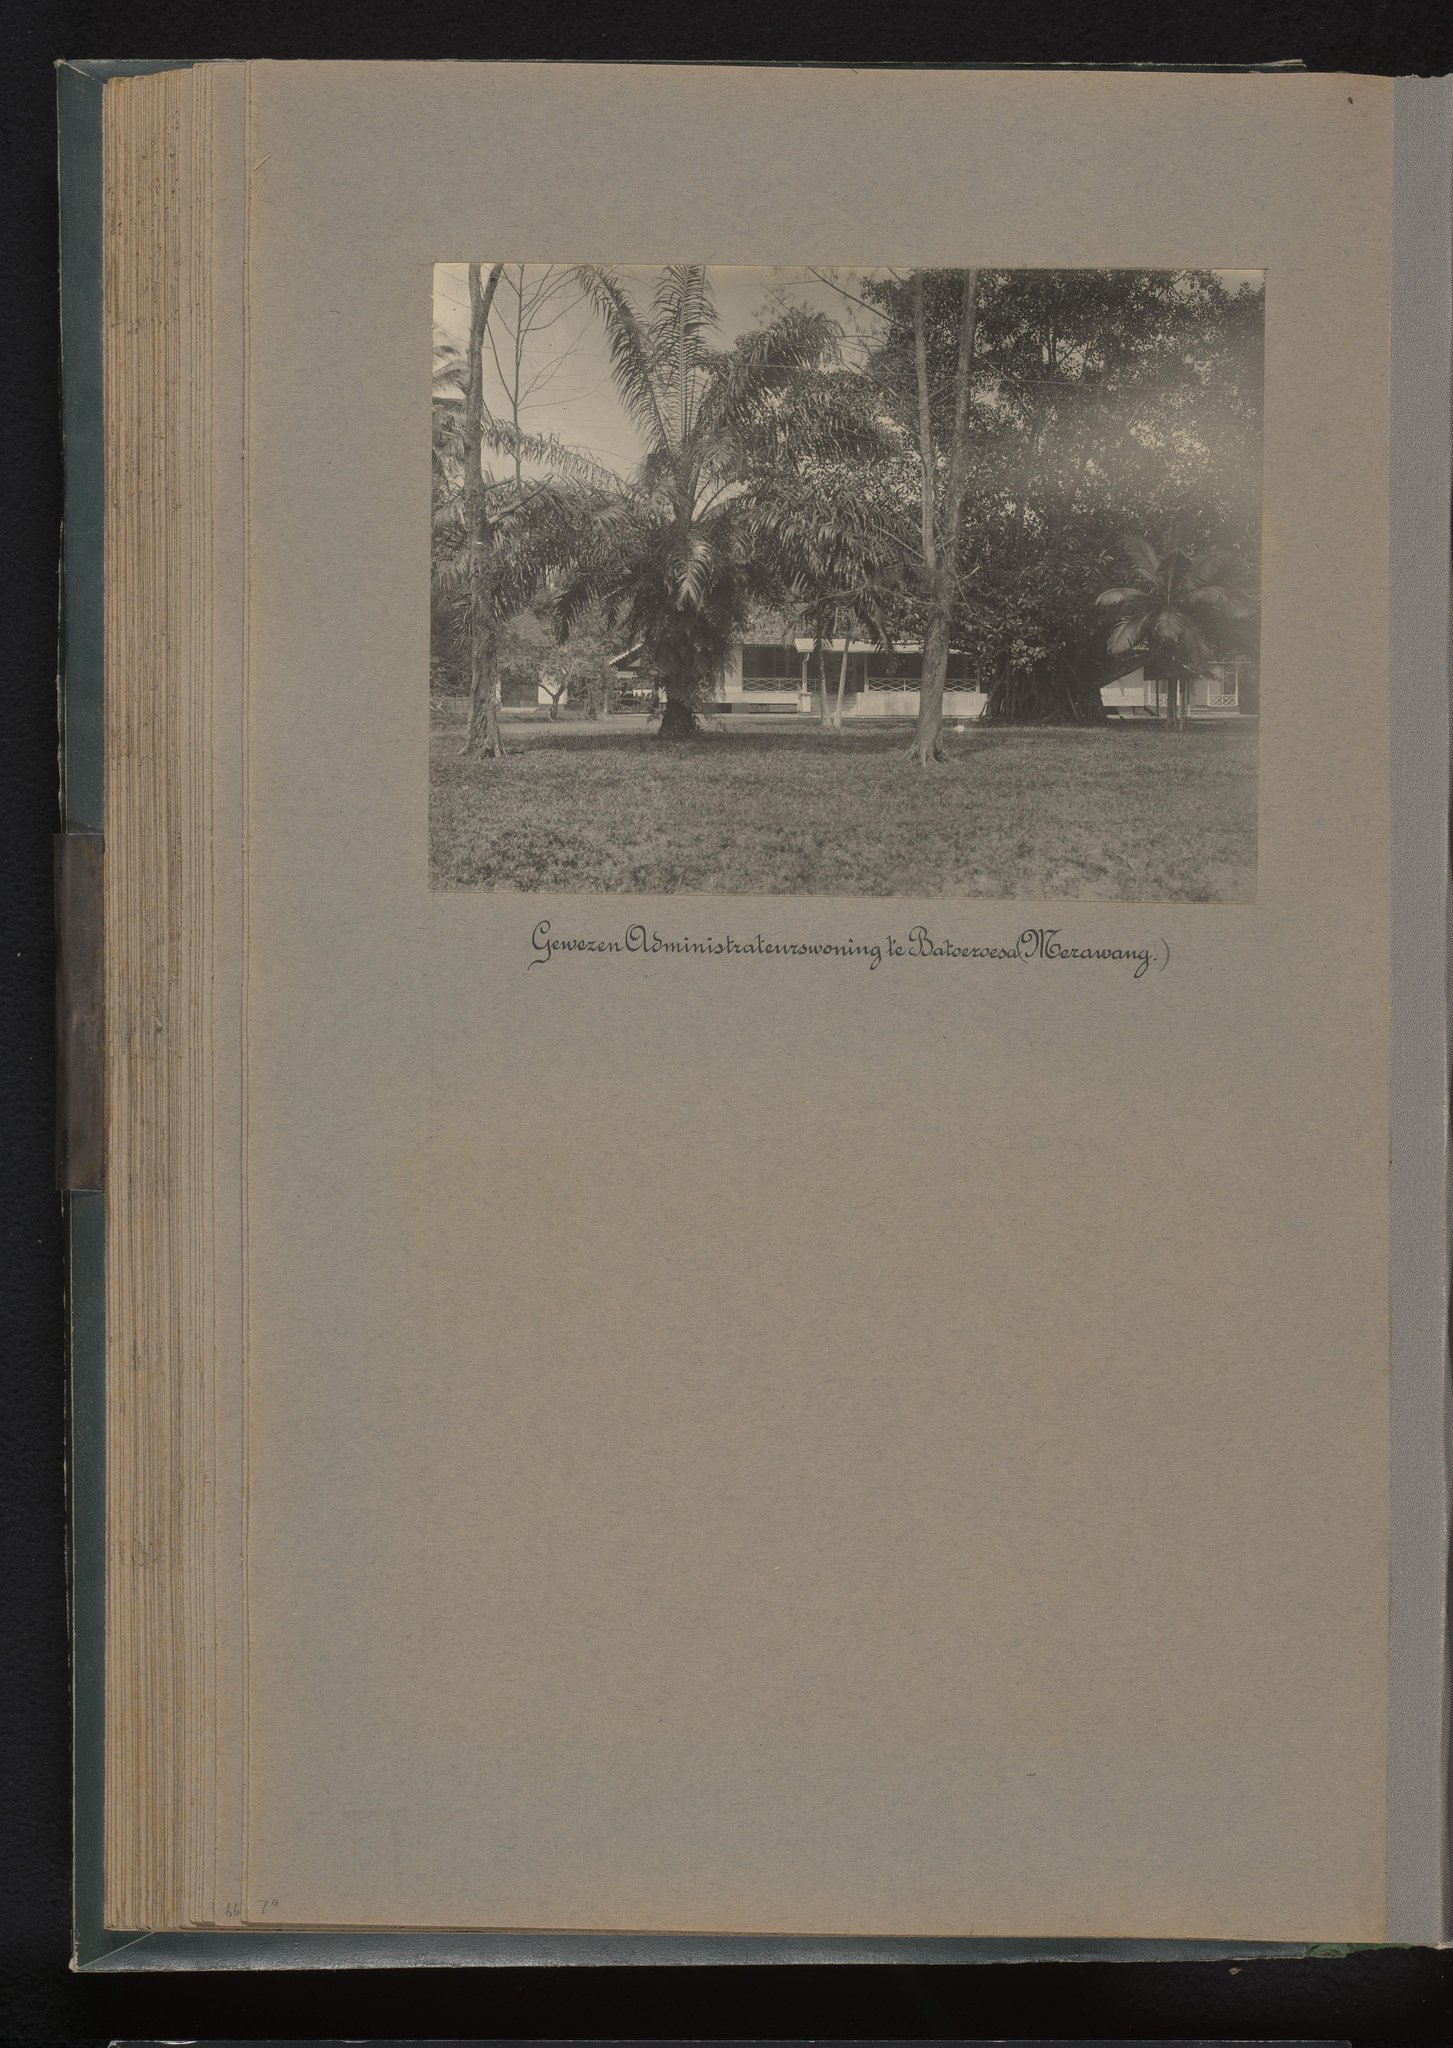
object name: photograph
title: Woning van de Banka-tinwinning te Merawang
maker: Anonymous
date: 1914-1919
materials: cardboard, photographic support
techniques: gelatin silver print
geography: bangka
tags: robert julius boers, colonial system, mining, villa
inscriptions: inscription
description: Albumblad met 1 foto van de administrateurswoning van de Banka-tinwinning te Merawang. Onderdeel van het fotoalbum aangeboden aan Robert Julius Boers bij zijn vertrek naar Nederland in 1919 door het personeel van de Banka-tinwinning.